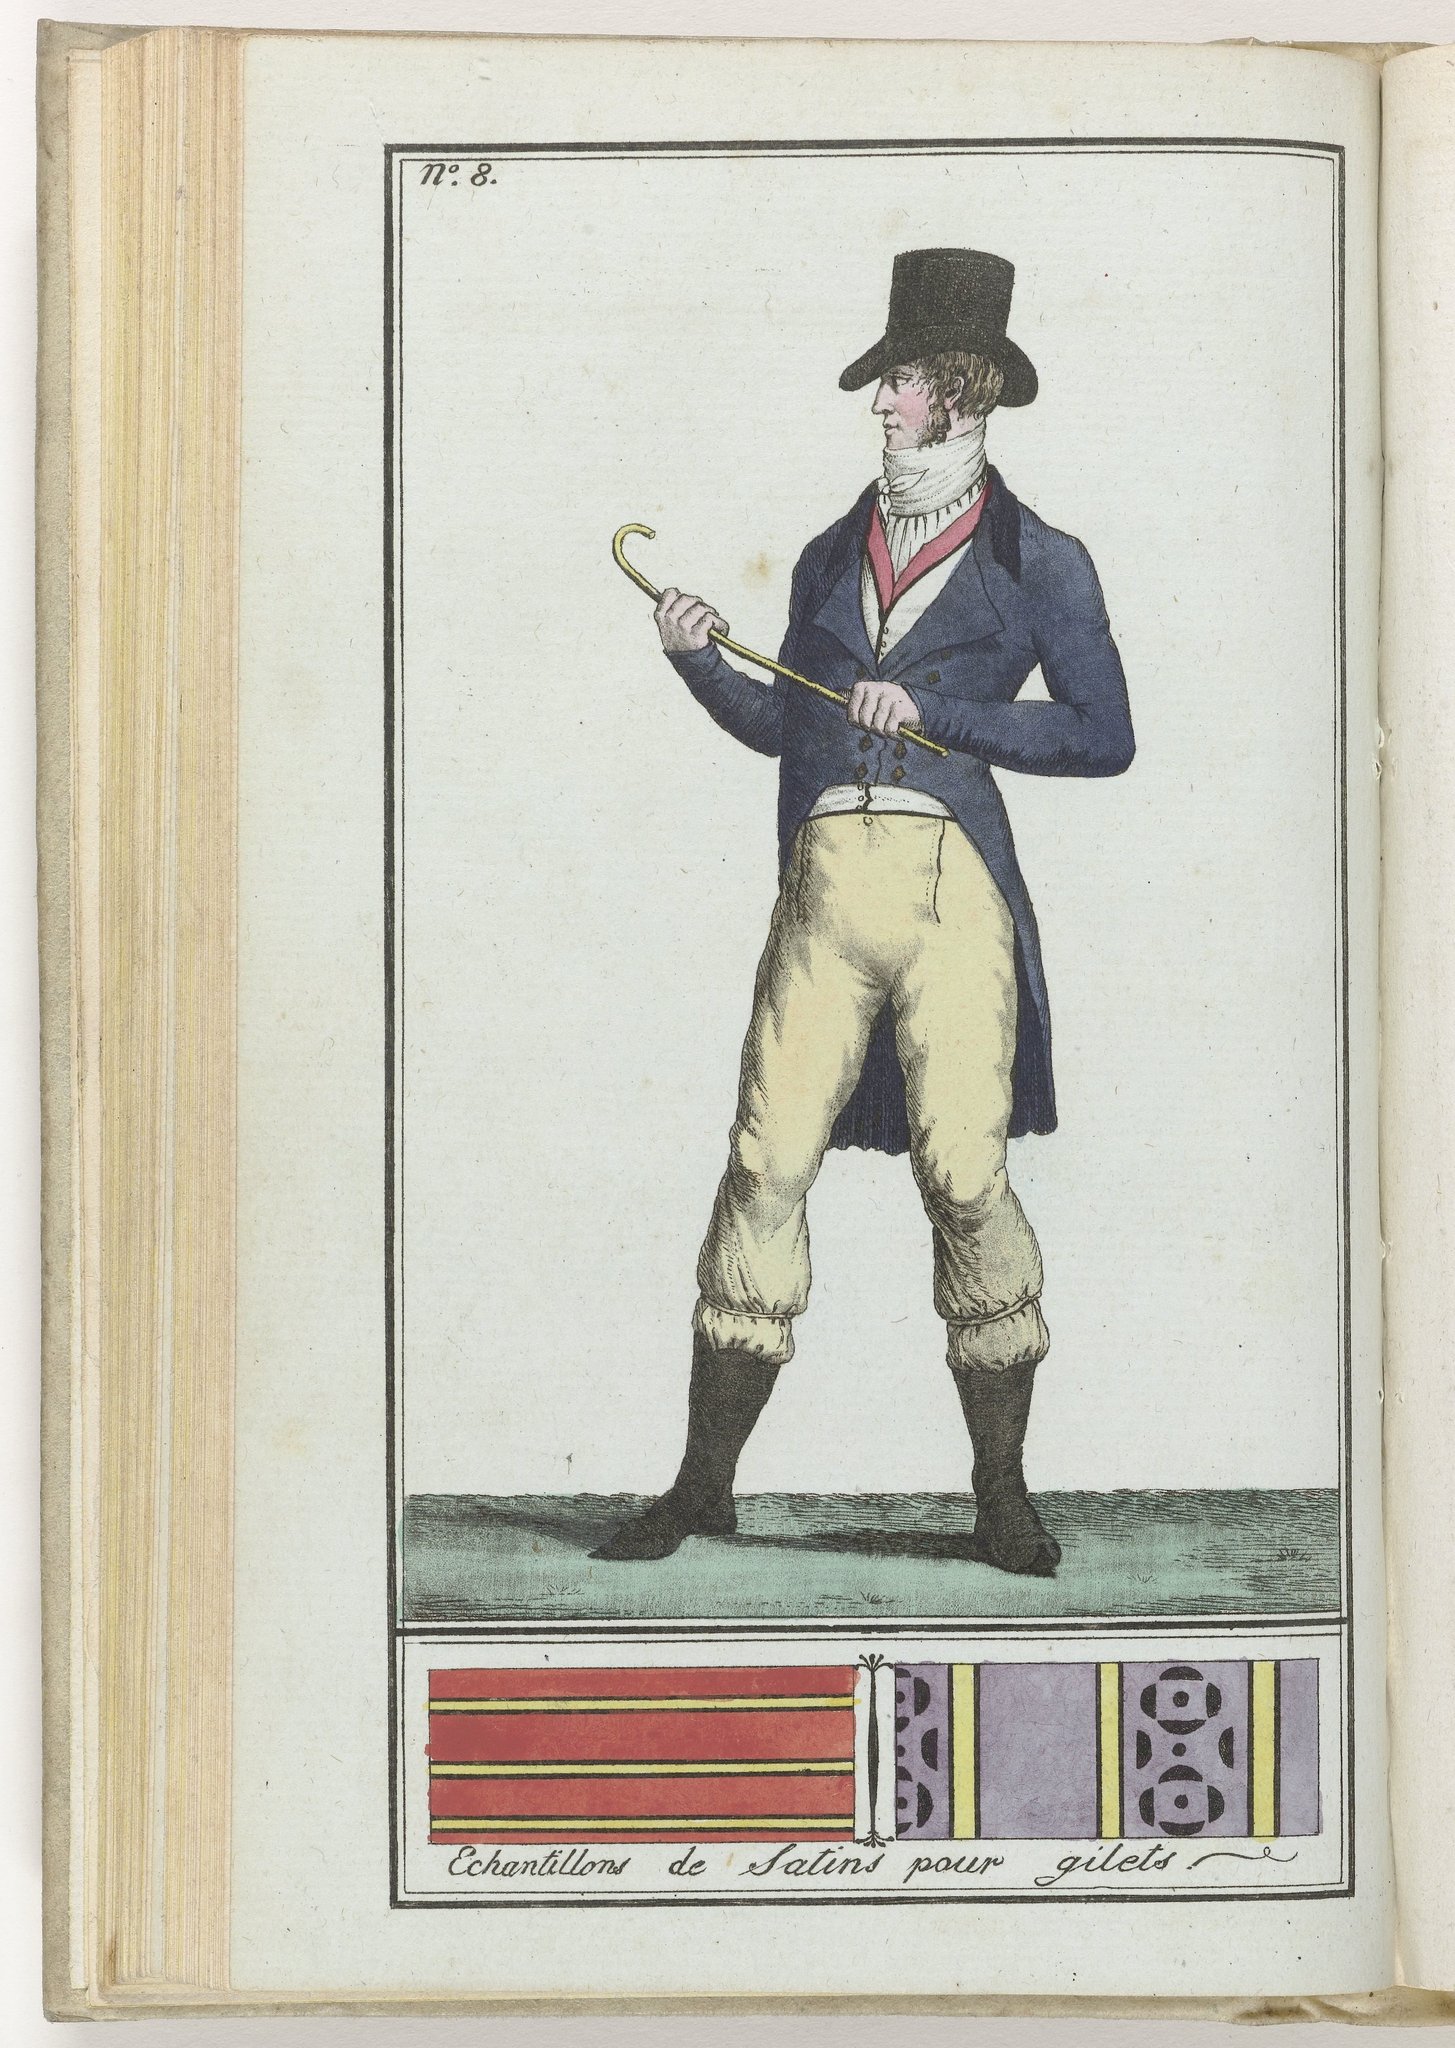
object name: fashion print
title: Le Mois, Journal historique, littéraire et critique, avec figures, Tome 3, No. 8, An. 8 (1799-1800) : Echantillons de Satins...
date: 1799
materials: paper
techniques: etching, hand coloring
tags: clothing for the upper part of the body (vest) (+ men's clothes), coat (+ men's clothes), fashion plates, boots (+ men's clothes), walking-stick, staff, cane (+ men's clothes)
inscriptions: inscription: ‘No. 8’, caption: ‘Echantillons de Satins pour gilets’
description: Man in profiel naar links, in gilet met hoge halsdoek, blauwe frak, een pantalon met banden om de kuiten (?) en laarzen. Hoge hoed. Kort kapsel met lange bakkebaarden. Rotting in de handen. Volgens de tekst in het tijdschrift is het een karikatuur van de heersende mode die vooral door de jongeren wordt gedragen en de lachlust van anderen opwekt. Onderaan 2 staaltjes van satijn voor gilets: 'Echantillons de Satins pour gilets'. Prent uit het tijdschrift Le Mois: Journal historique, littéraire et critique avec figures, An 7 en 8 (1798-1800).